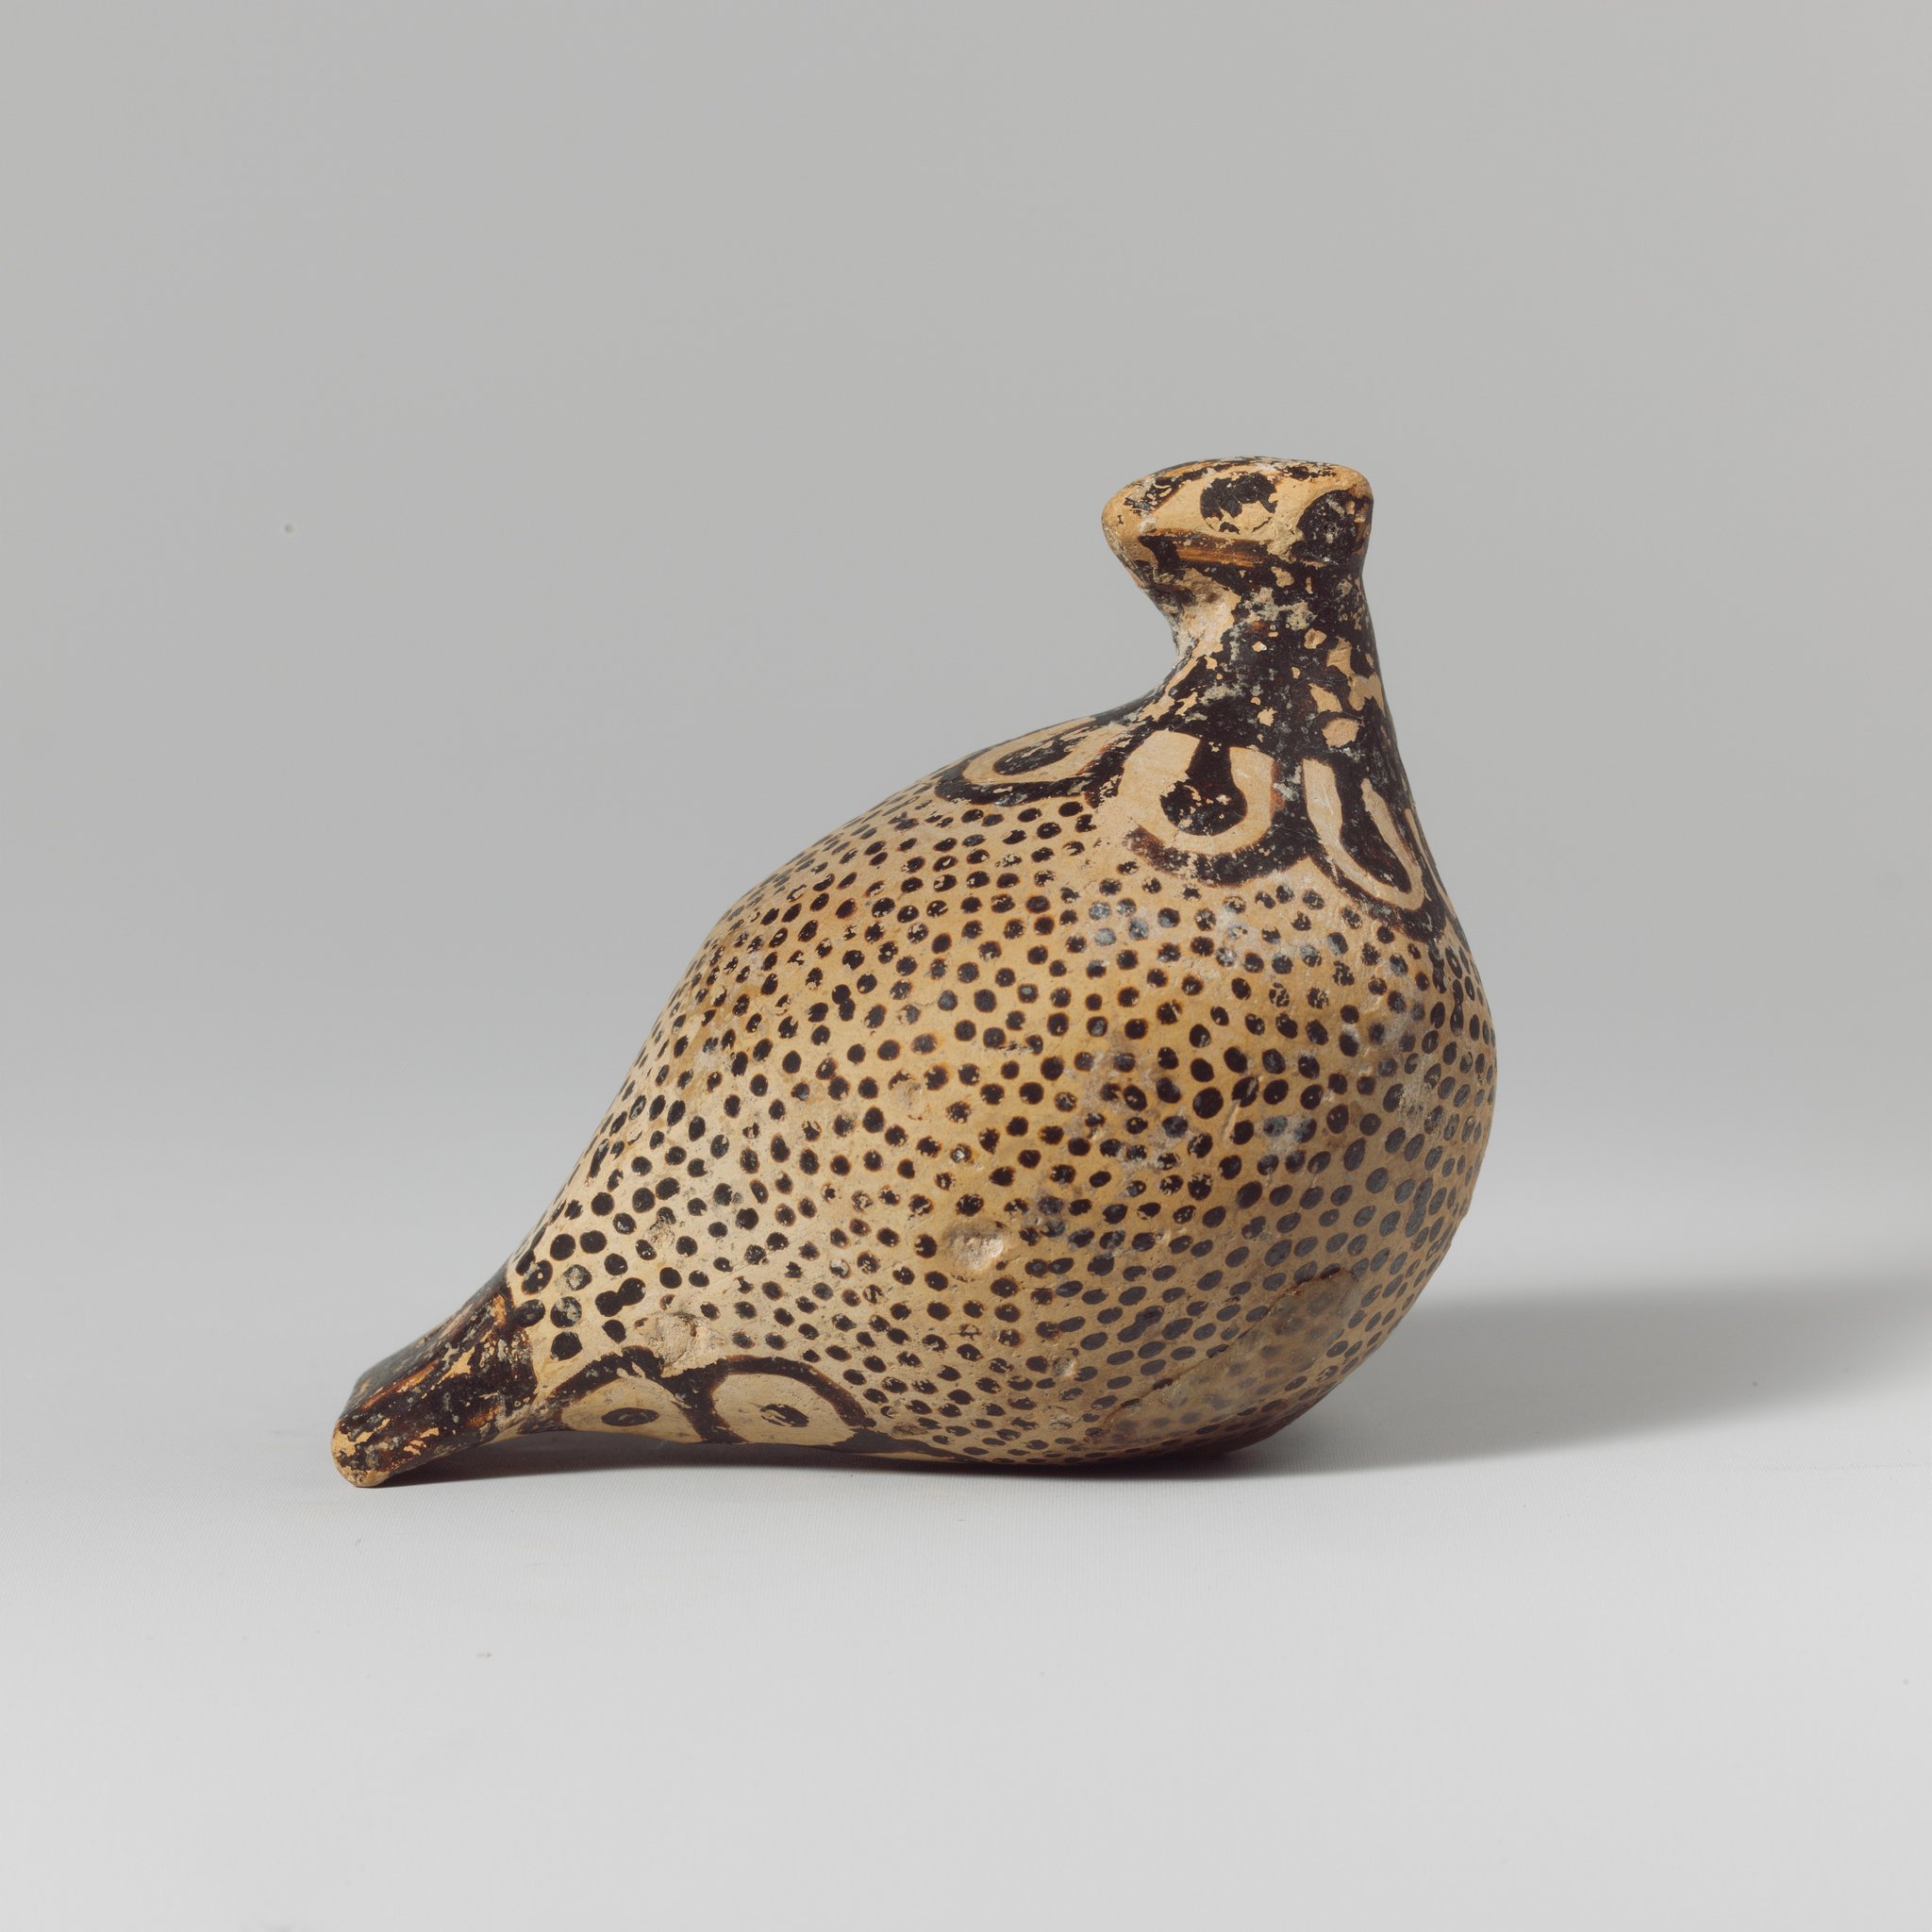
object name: aryballos in the form of a bird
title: Terracotta vase in the form of a bird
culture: greek, corinthian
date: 620-590 BCE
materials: terracotta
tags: birds